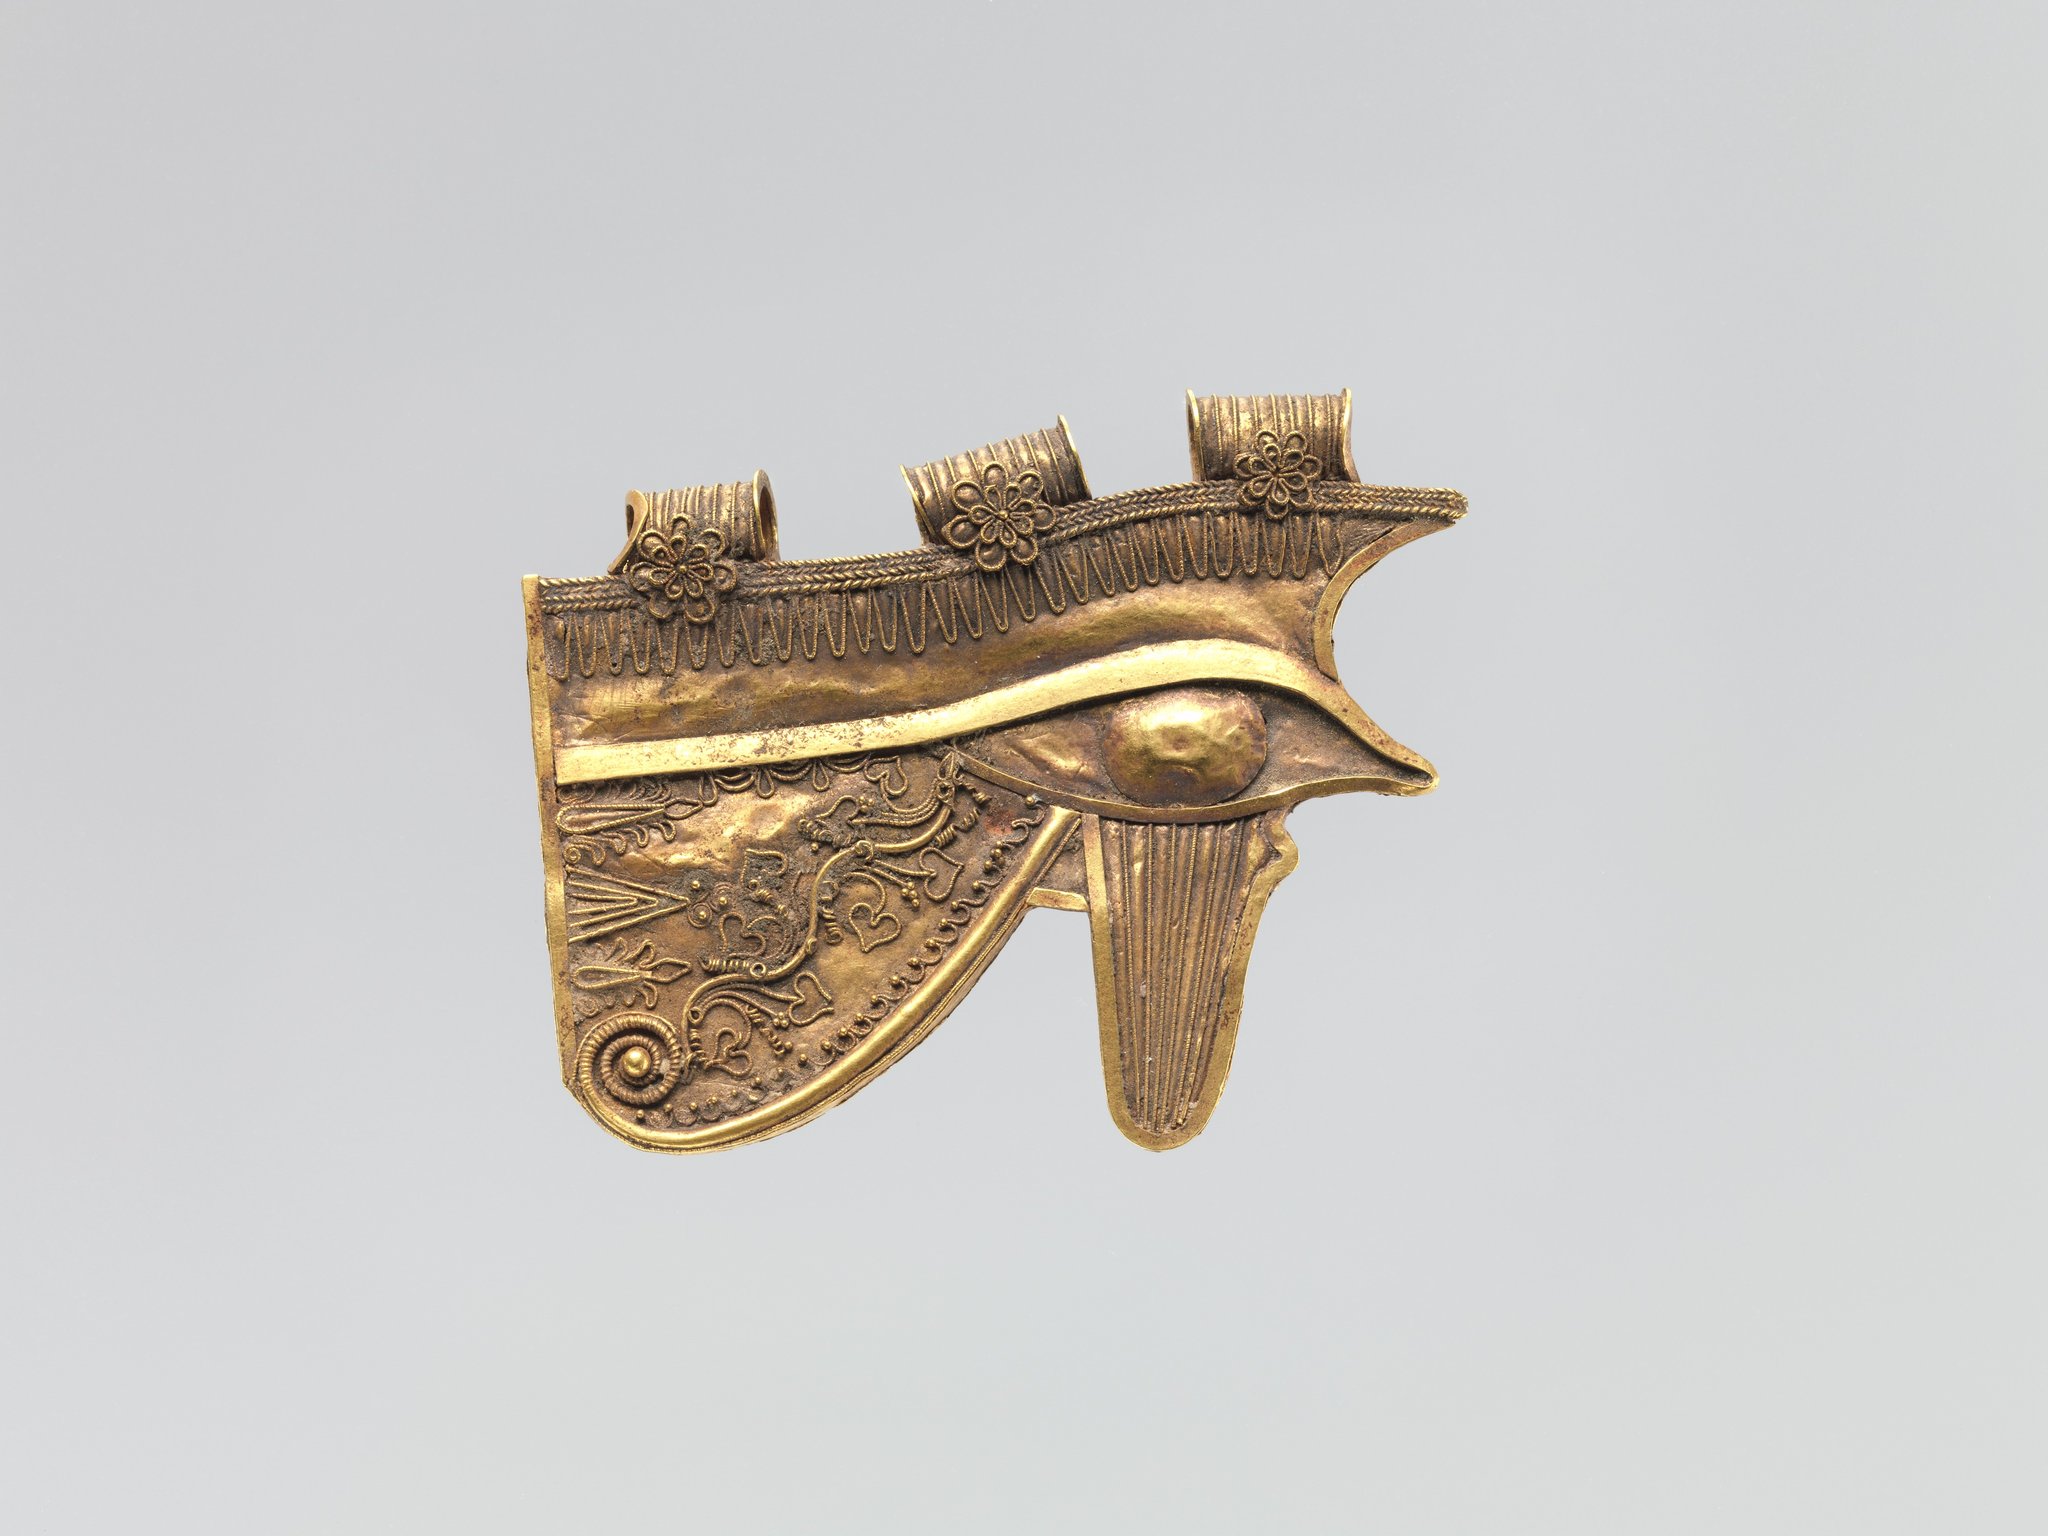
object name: amulet, wedjat eye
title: Wedjat eye with granulation and decorative wire ornament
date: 332-330 BCE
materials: gold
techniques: filigree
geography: egypt